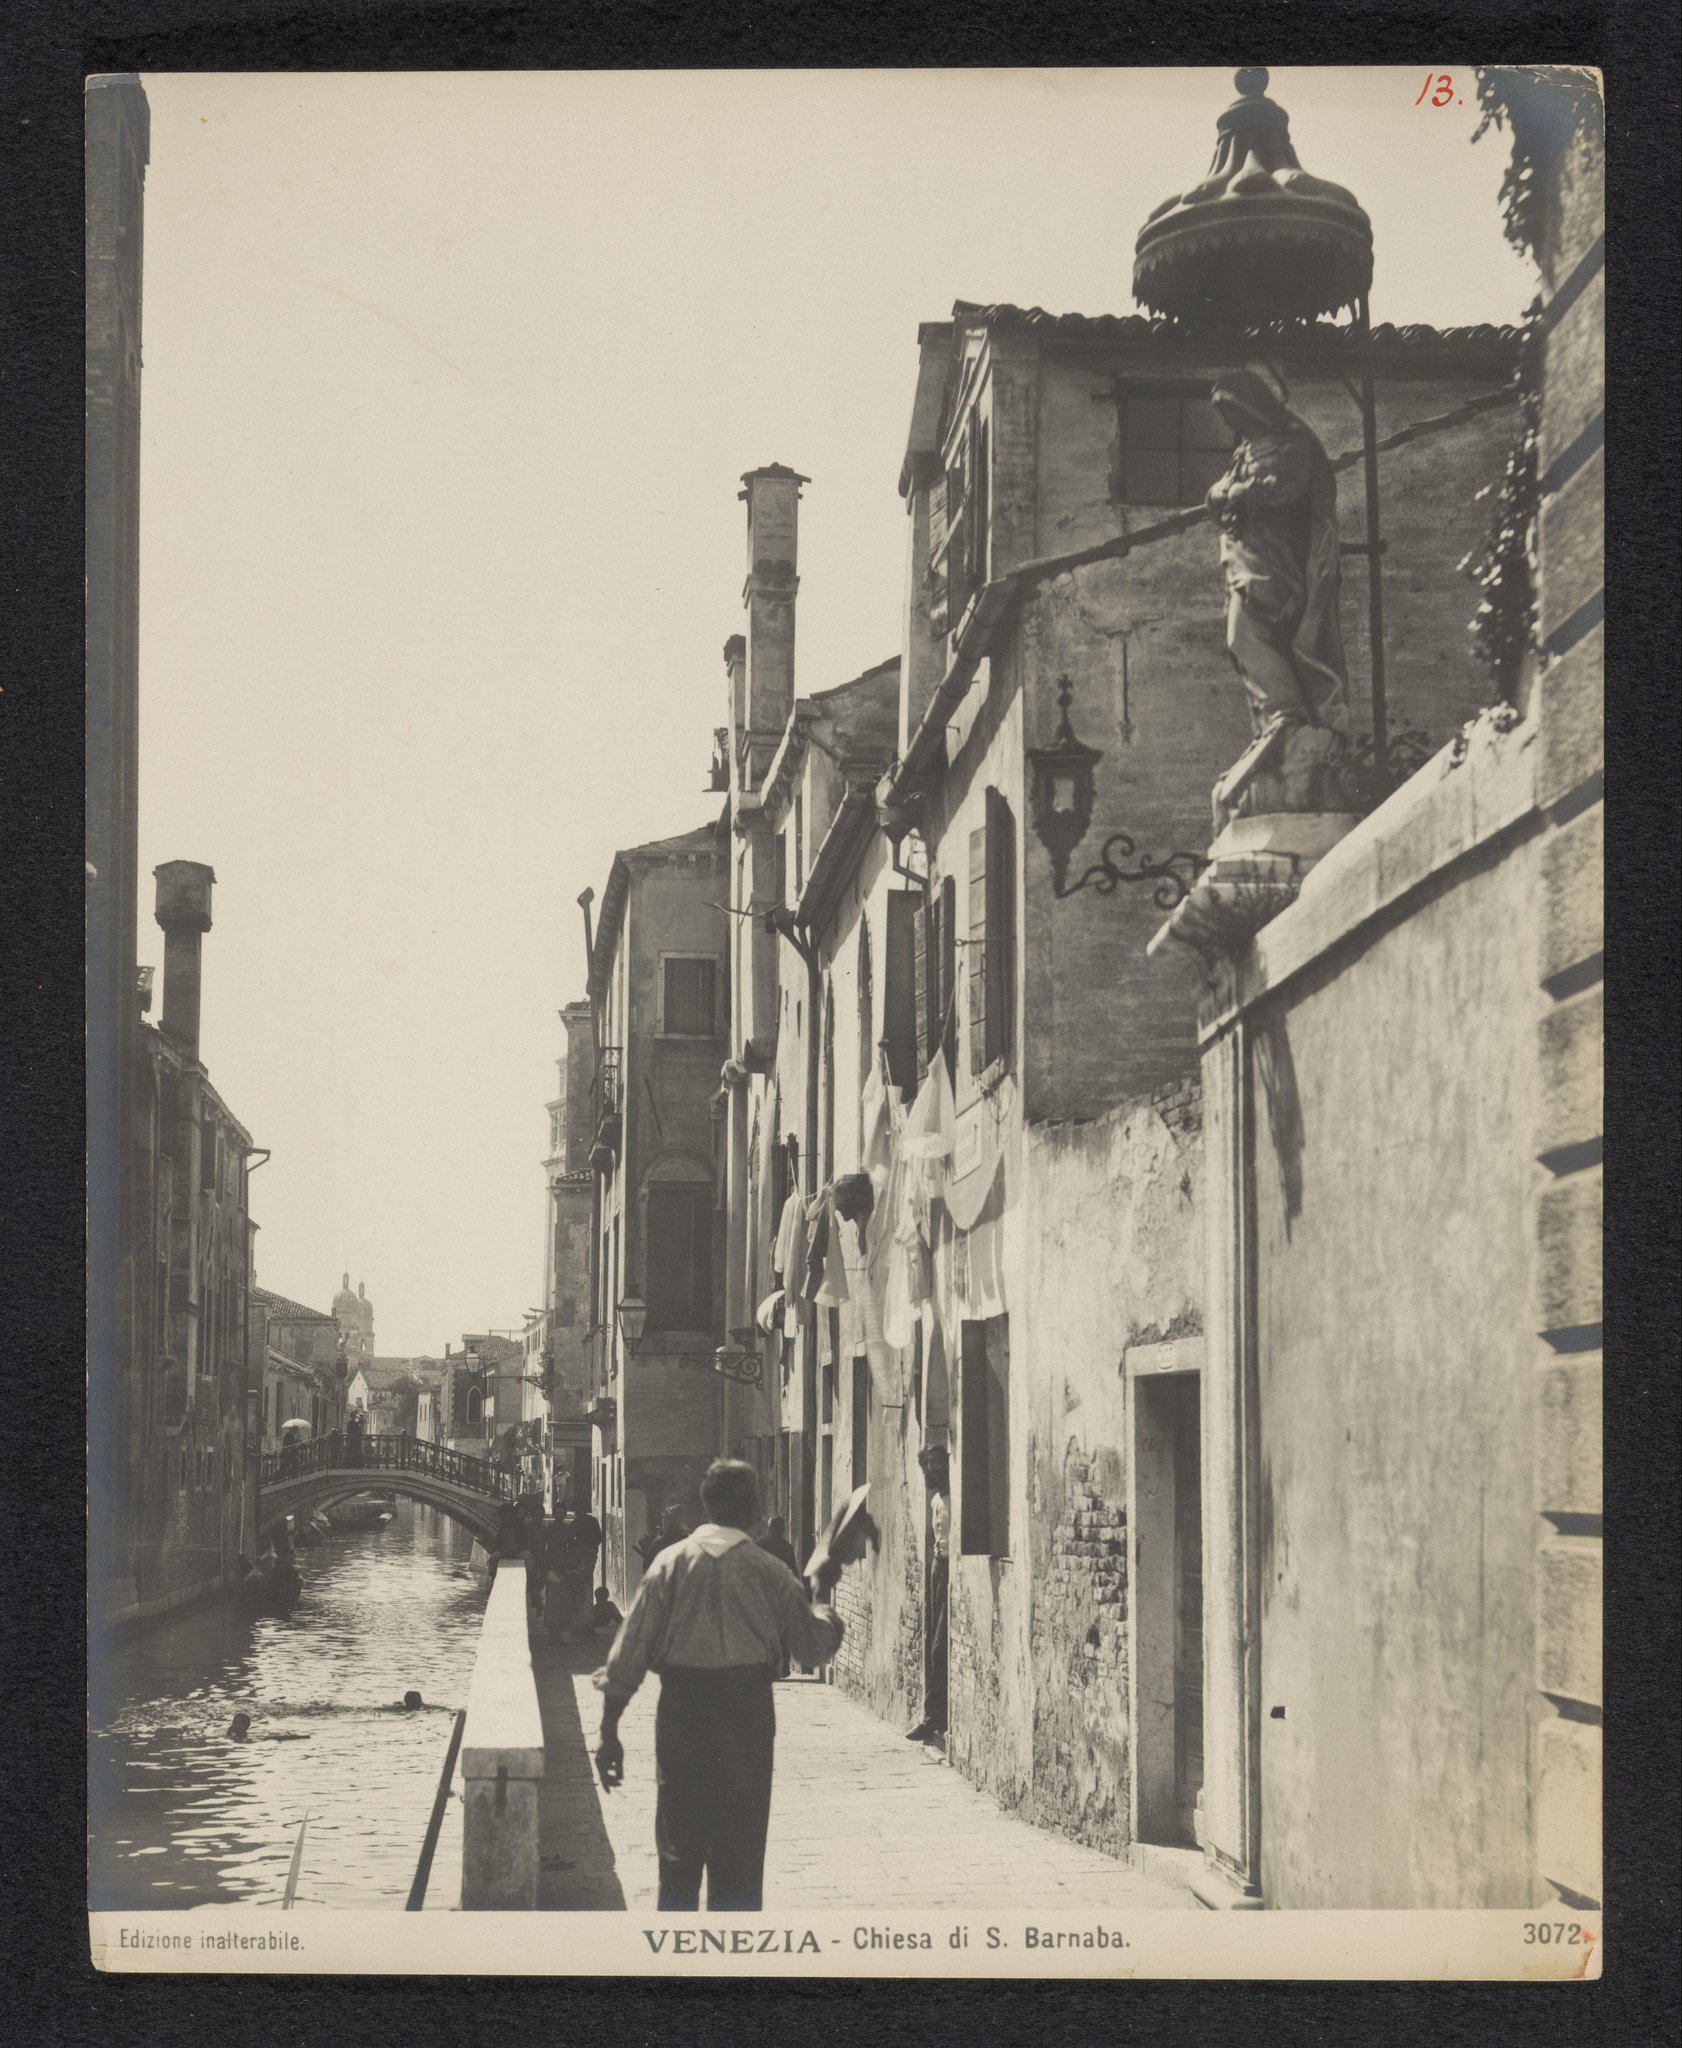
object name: photograph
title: Venezia - Chiesa di S. Barnaba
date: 1900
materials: cardboard, photographic support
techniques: gelatin silver print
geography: venice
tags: canal, gondola, quay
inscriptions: number: ‘3072’, inscription: ‘Rijksnormaalschool voor Teekenonderwijzers Amsterdam’, number: ‘13.’